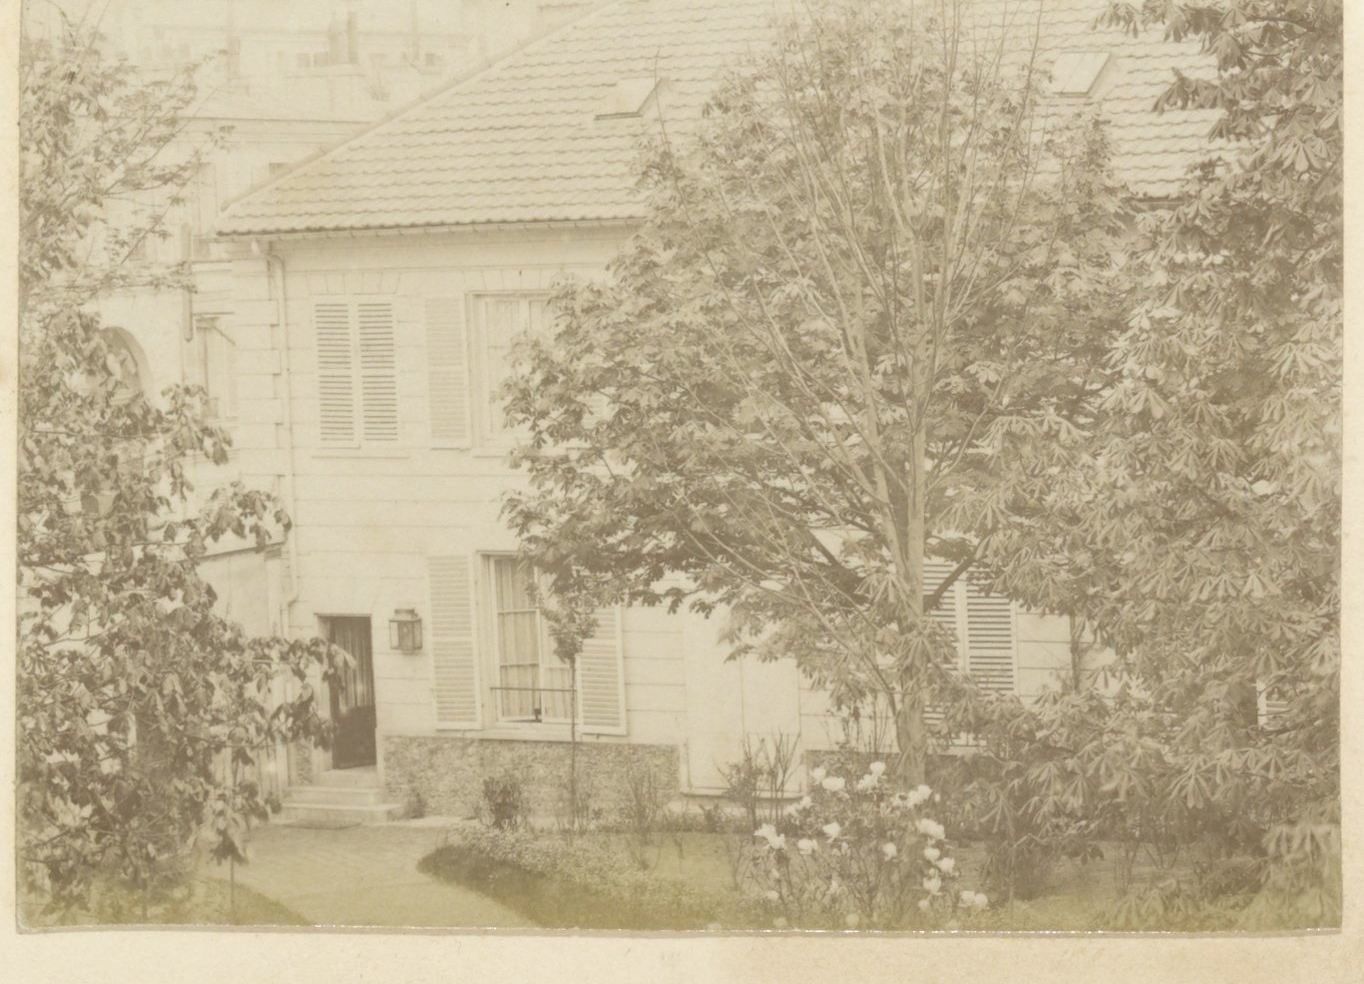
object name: photograph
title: Gezicht op de gevel van een huis met tuin in Frankrijk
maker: Anonymous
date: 1900-1910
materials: paper, photographic support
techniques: albumen print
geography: france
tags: garden, façade (of house or building), france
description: Onderdeel van Fotoalbum van een Franse amateurfotograaf met opnames van een familie, distilleerderij Delizy & Doistau Fils, het leger en bezienswaardigheden in Frankrijk.